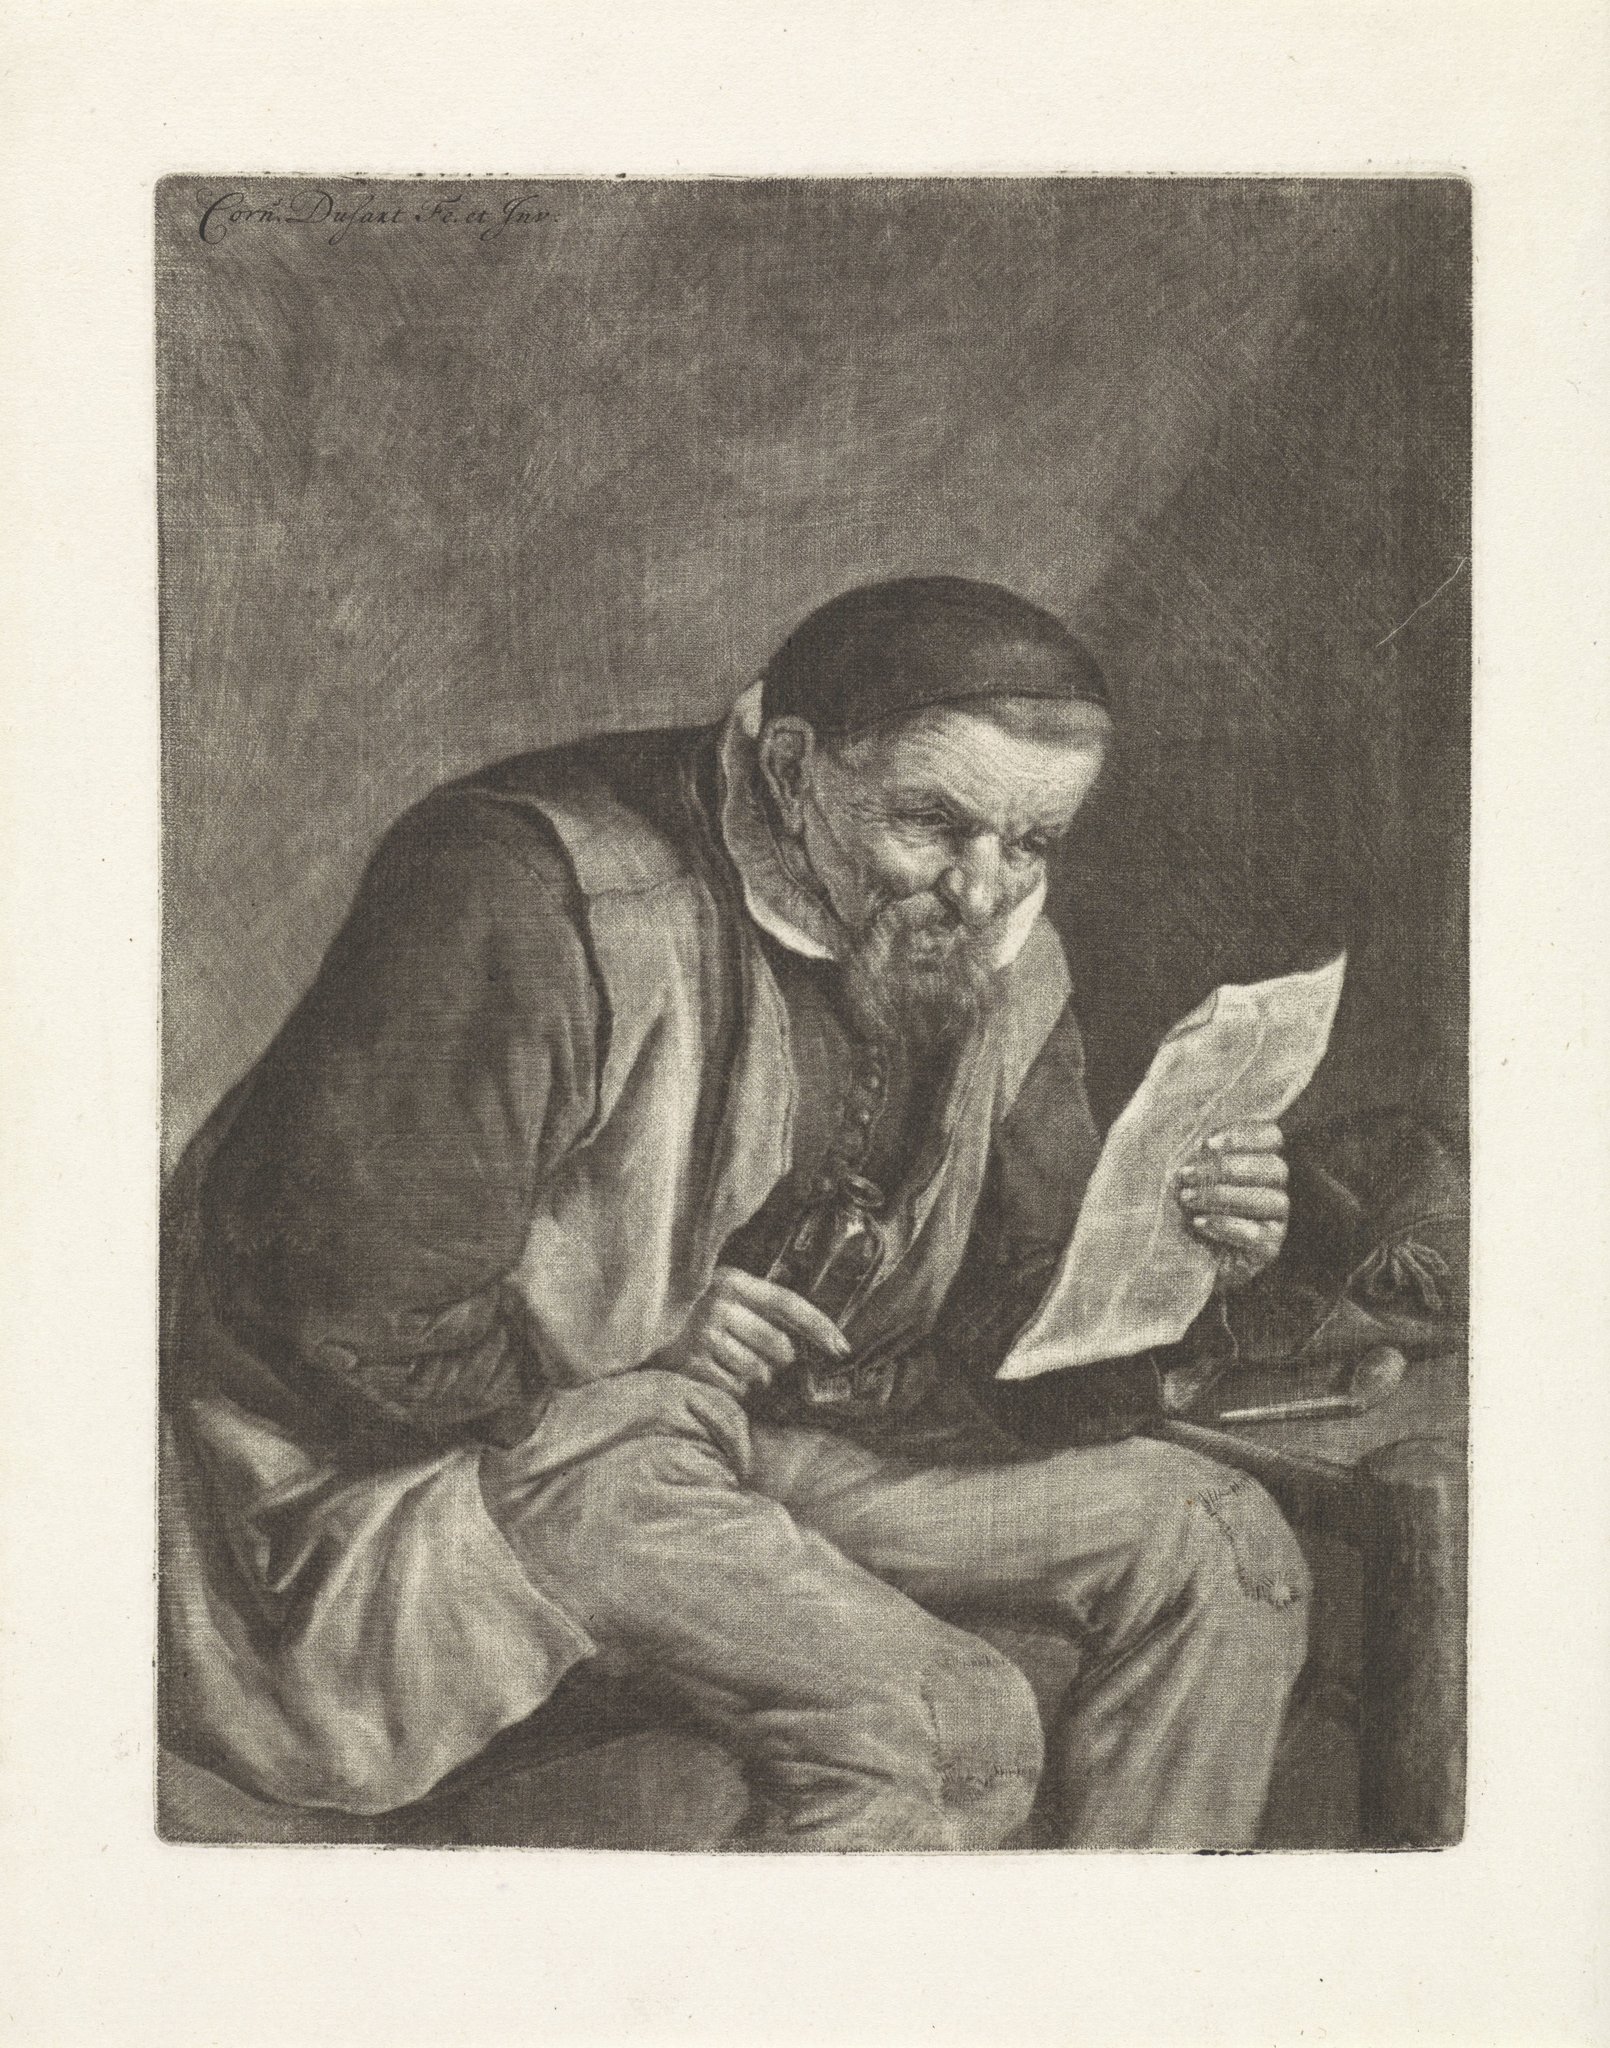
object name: print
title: Brieflezende boer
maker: cornelis dusart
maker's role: draughtsman, painter, print maker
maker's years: 1660-1704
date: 1679-1704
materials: paper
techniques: mezzotint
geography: haarlem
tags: reading, letter, envelope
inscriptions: collector's mark: Lugt 240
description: Een boer zit een brief te lezen en houdt in zijn hand een flesje drank. Op het tafeltje naast hem ligt een pijp.